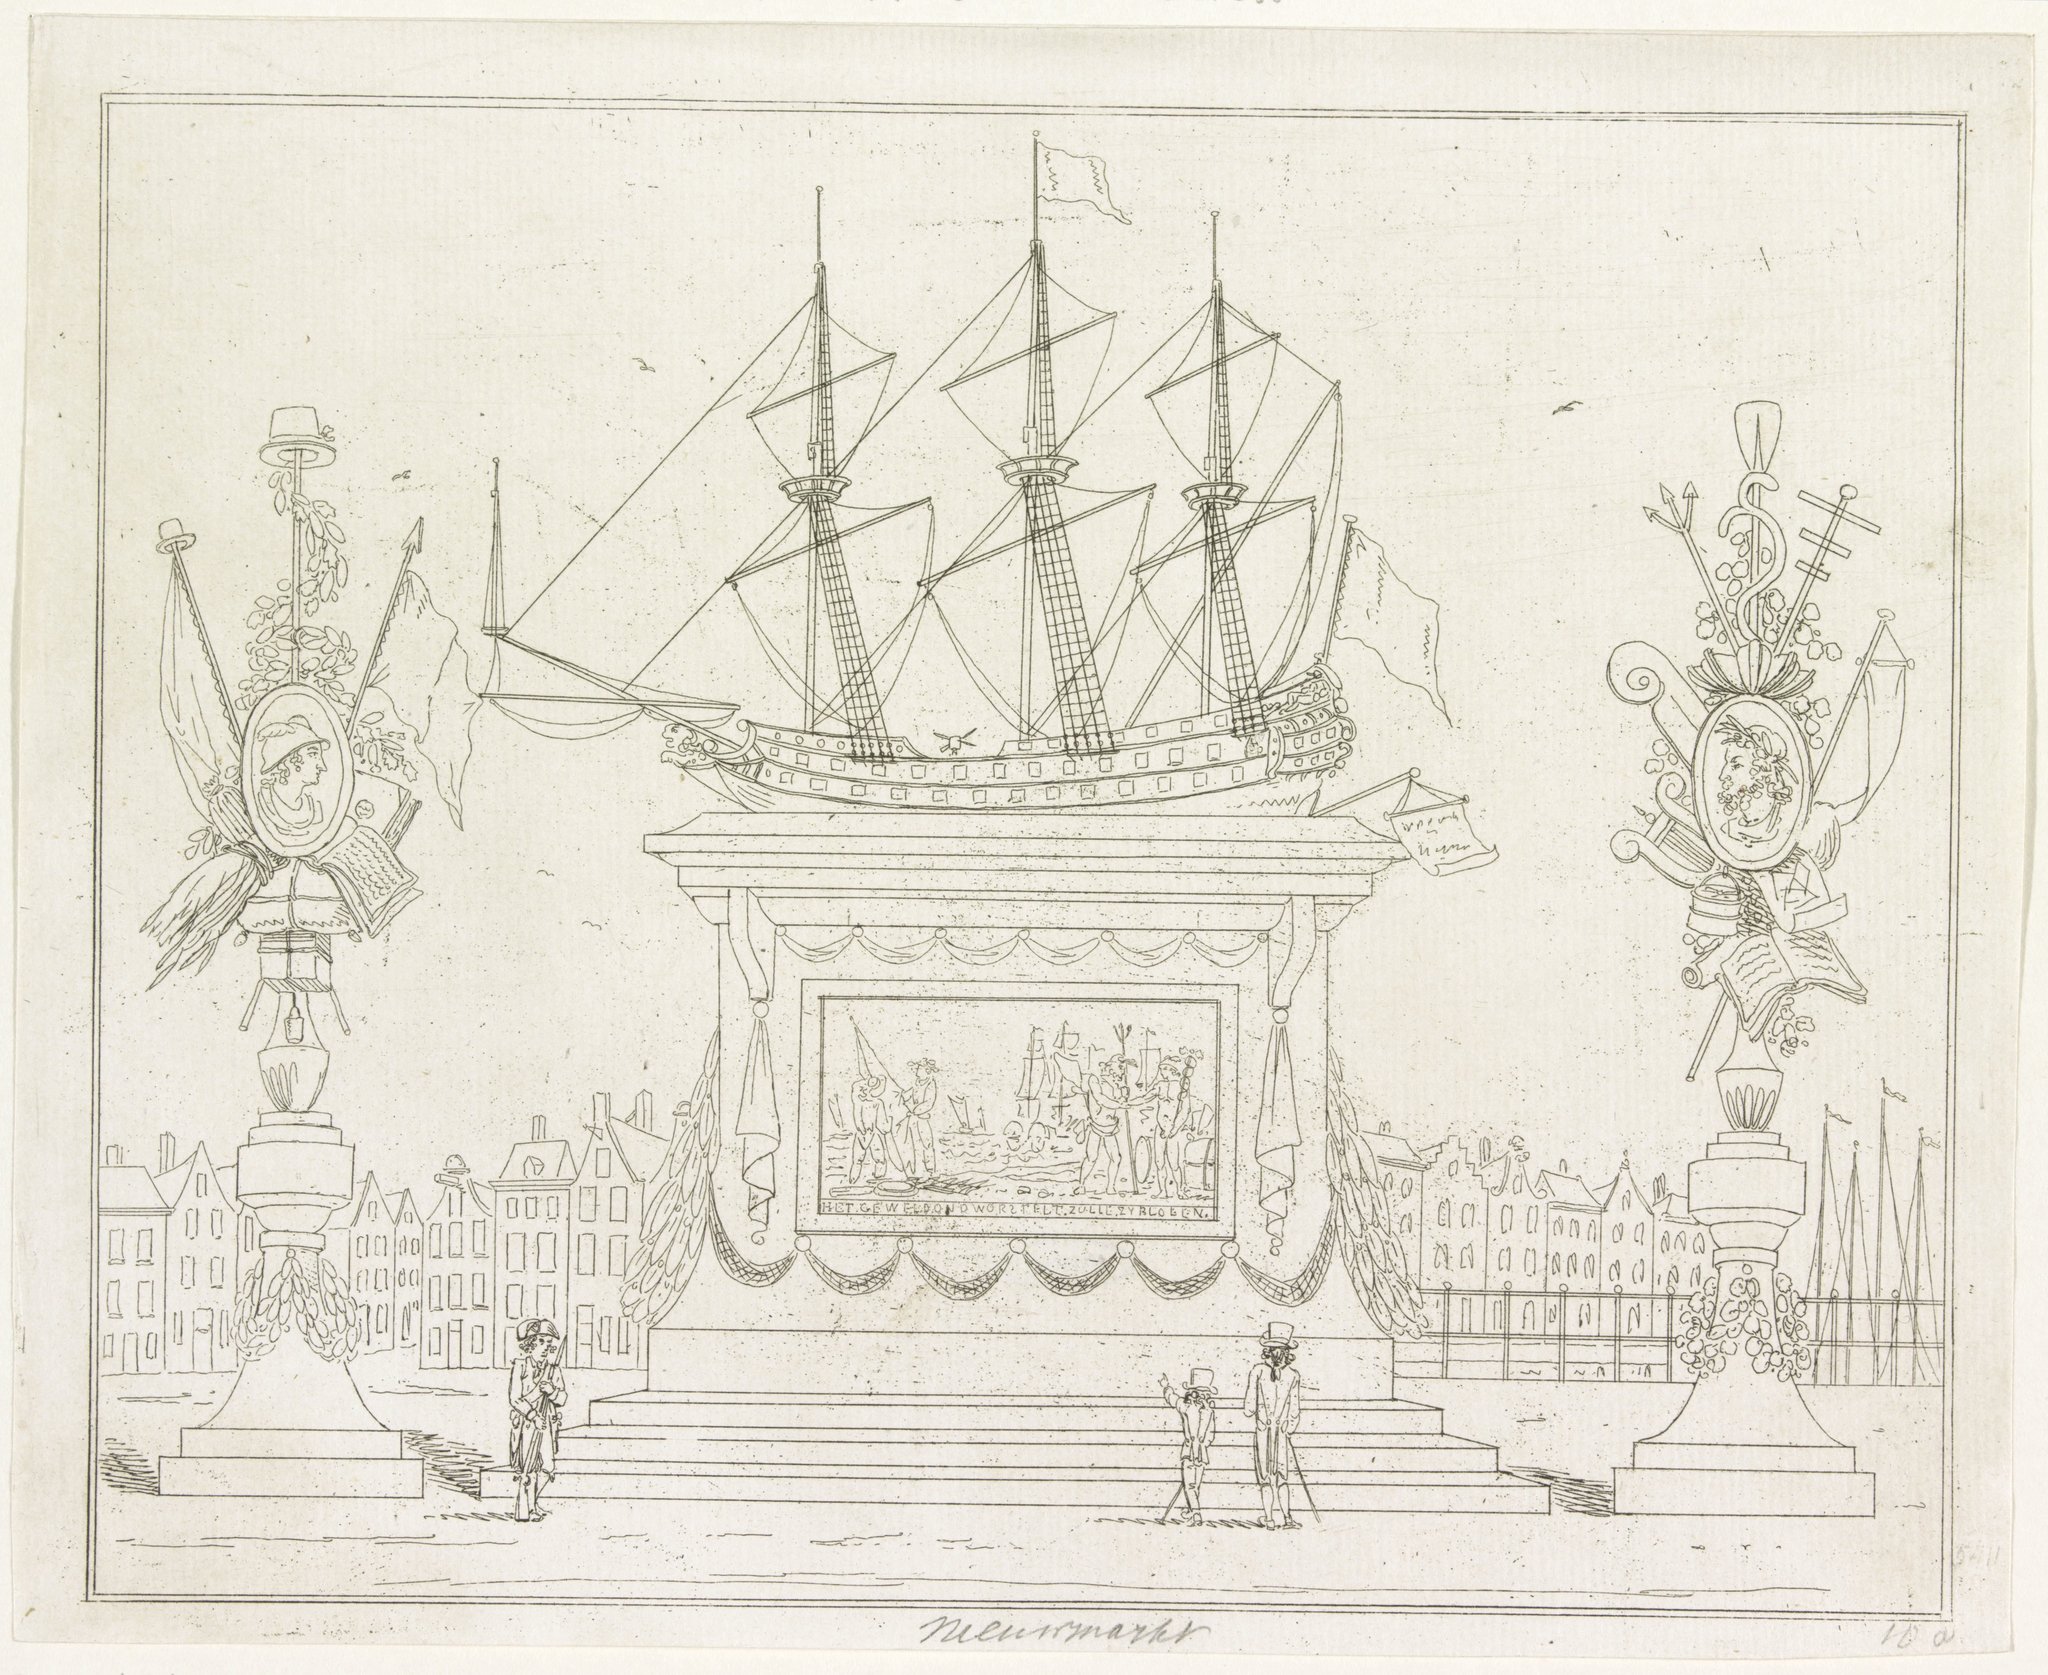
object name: print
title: Tien platen van de decoraties bij het Alliantiefeest te Amsterdam in 1795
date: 1795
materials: paper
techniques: etching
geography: amsterdam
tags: ship-model (+ propulsion of vehicle, ship, etc. by wind), festivities on events of national importance (+ festive decoration ~ festive activities), amsterdam, alliance with france (1795)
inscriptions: collector's mark: Lugt 2228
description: Koophandel en Zeevaart, allegorische decoratie opgericht in de Nieuwmarkt te Amsterdam bij het Alliantiefeest op 19 juni 1795. Reusachtig model van een koopvaardijschip op een voetstuk met chassinet met voorstelling van Neptunus en Mercurius die elkaar de hand schudden terwijl de Franse en Bataafse matroos de Britse vlag aan stukken scheuren. Onderdeel van een serie van tien platen.